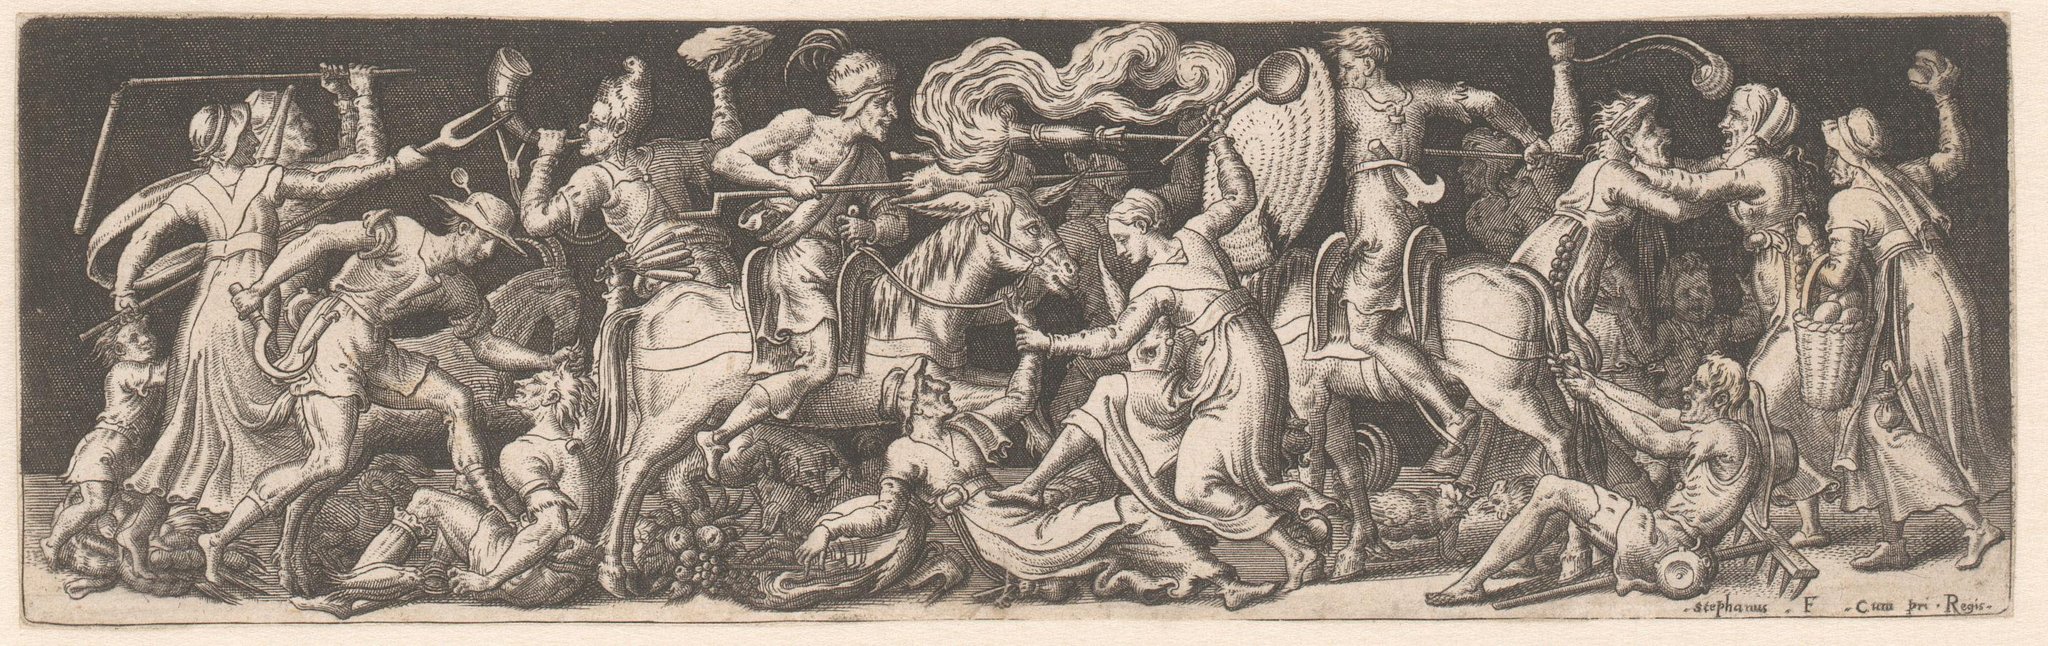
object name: print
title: Combats et triomphes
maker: etienne delaune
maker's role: draughtsman, goldsmith, print maker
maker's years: 1519-1583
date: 1528-1583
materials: paper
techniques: engraving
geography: france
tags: battle, hand-to-hand fighting (~ battle)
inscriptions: collector's mark: Lugt 240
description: Maakt deel uit van een twaalfdelige serie met gevechten en optochten tegen een donkere achtergrond.